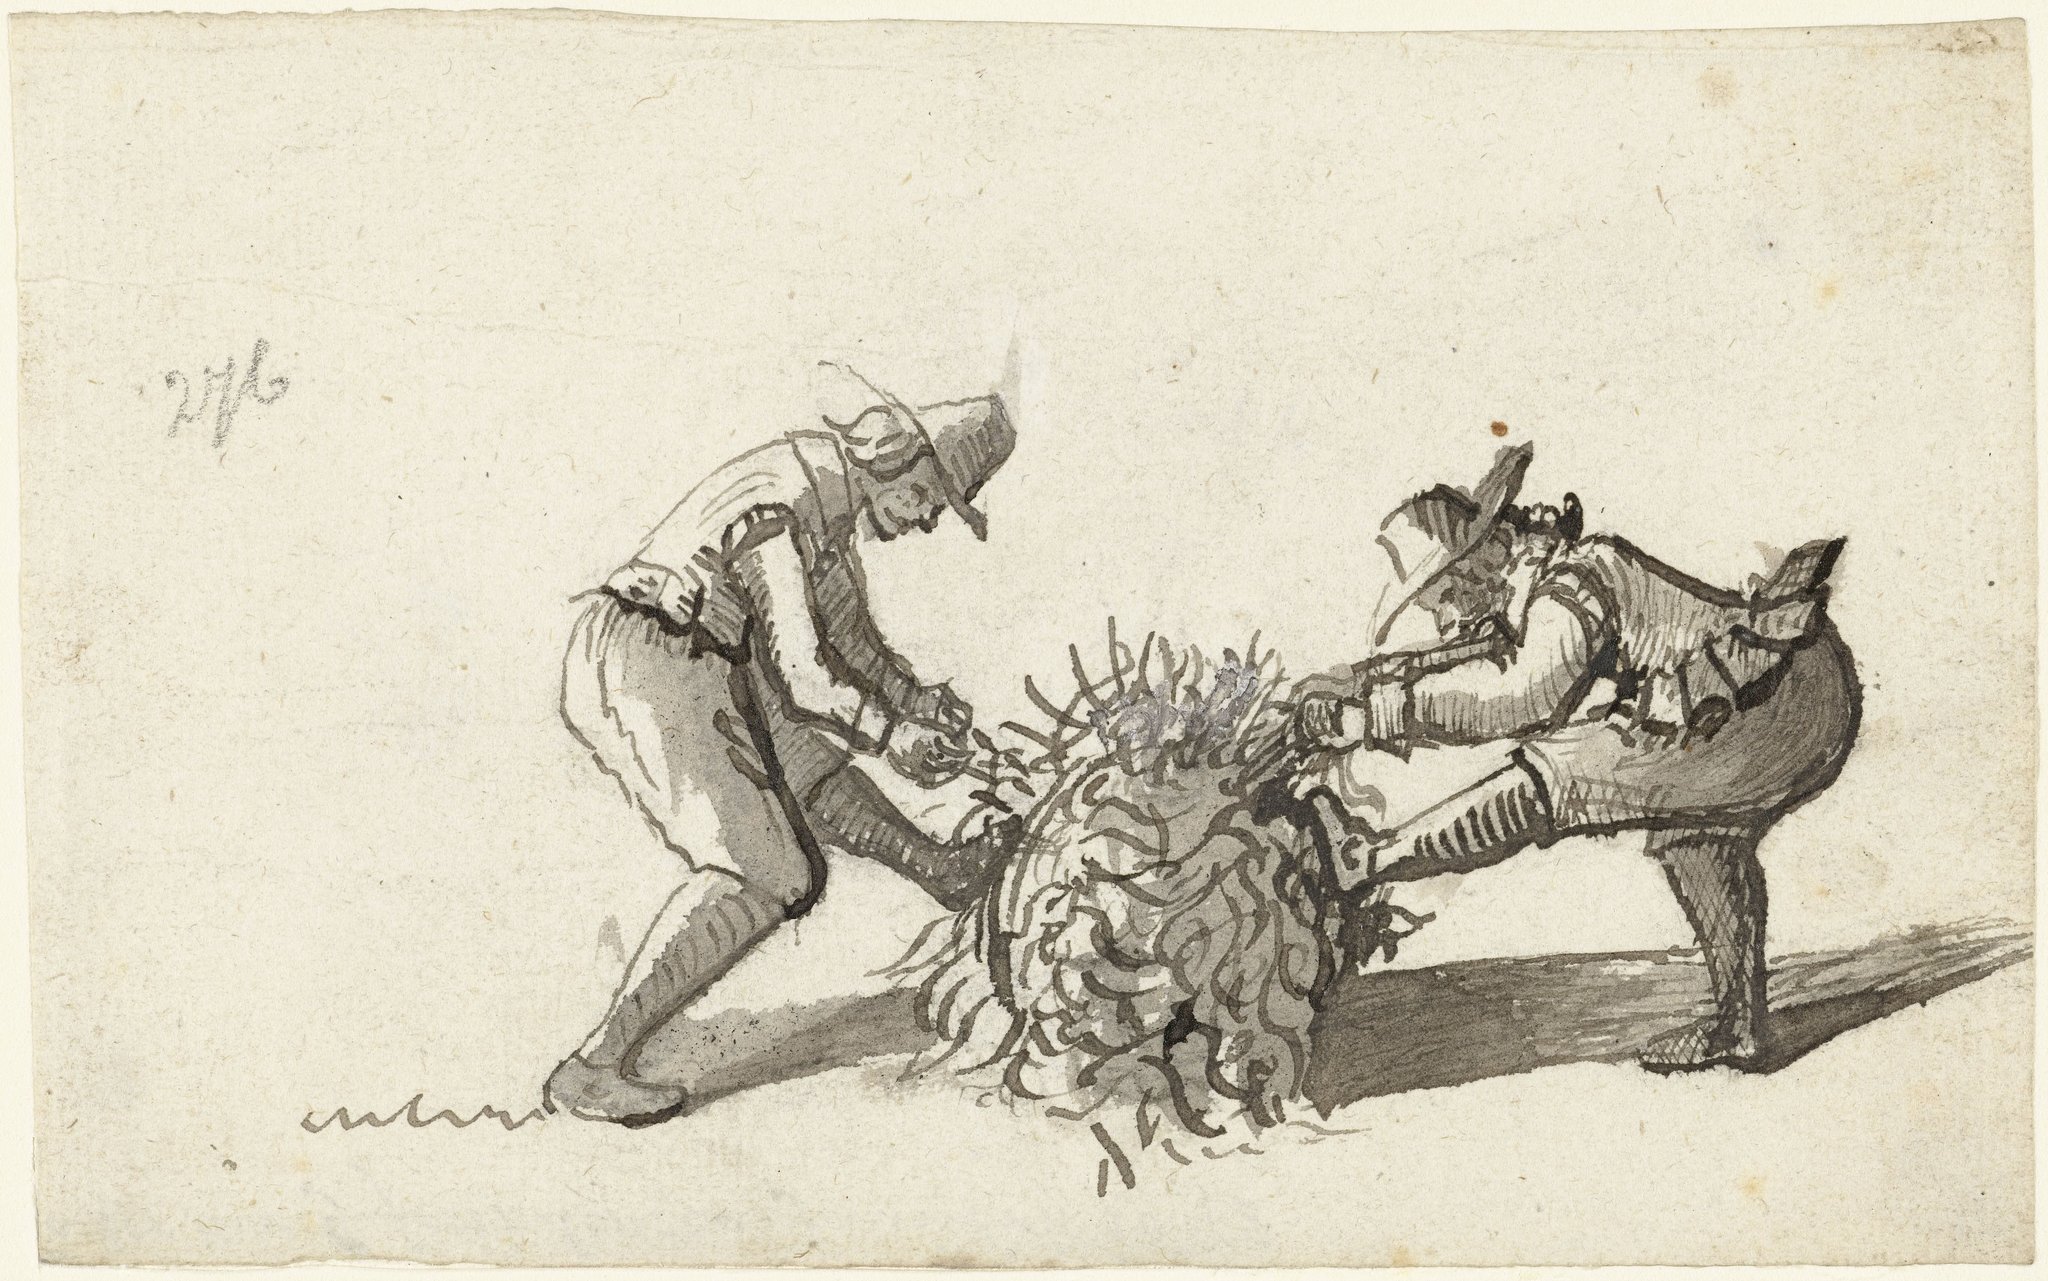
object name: drawing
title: Twee mannen die een vacht of een takkenbos samenbinden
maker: harmen ter borch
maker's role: draughtsman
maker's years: 1638-1677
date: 1648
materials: chalk, ink, paper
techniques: brush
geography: zwolle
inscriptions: annotation: ‘Ha[rmen] ter Borch.fecit den 20 January 1648’